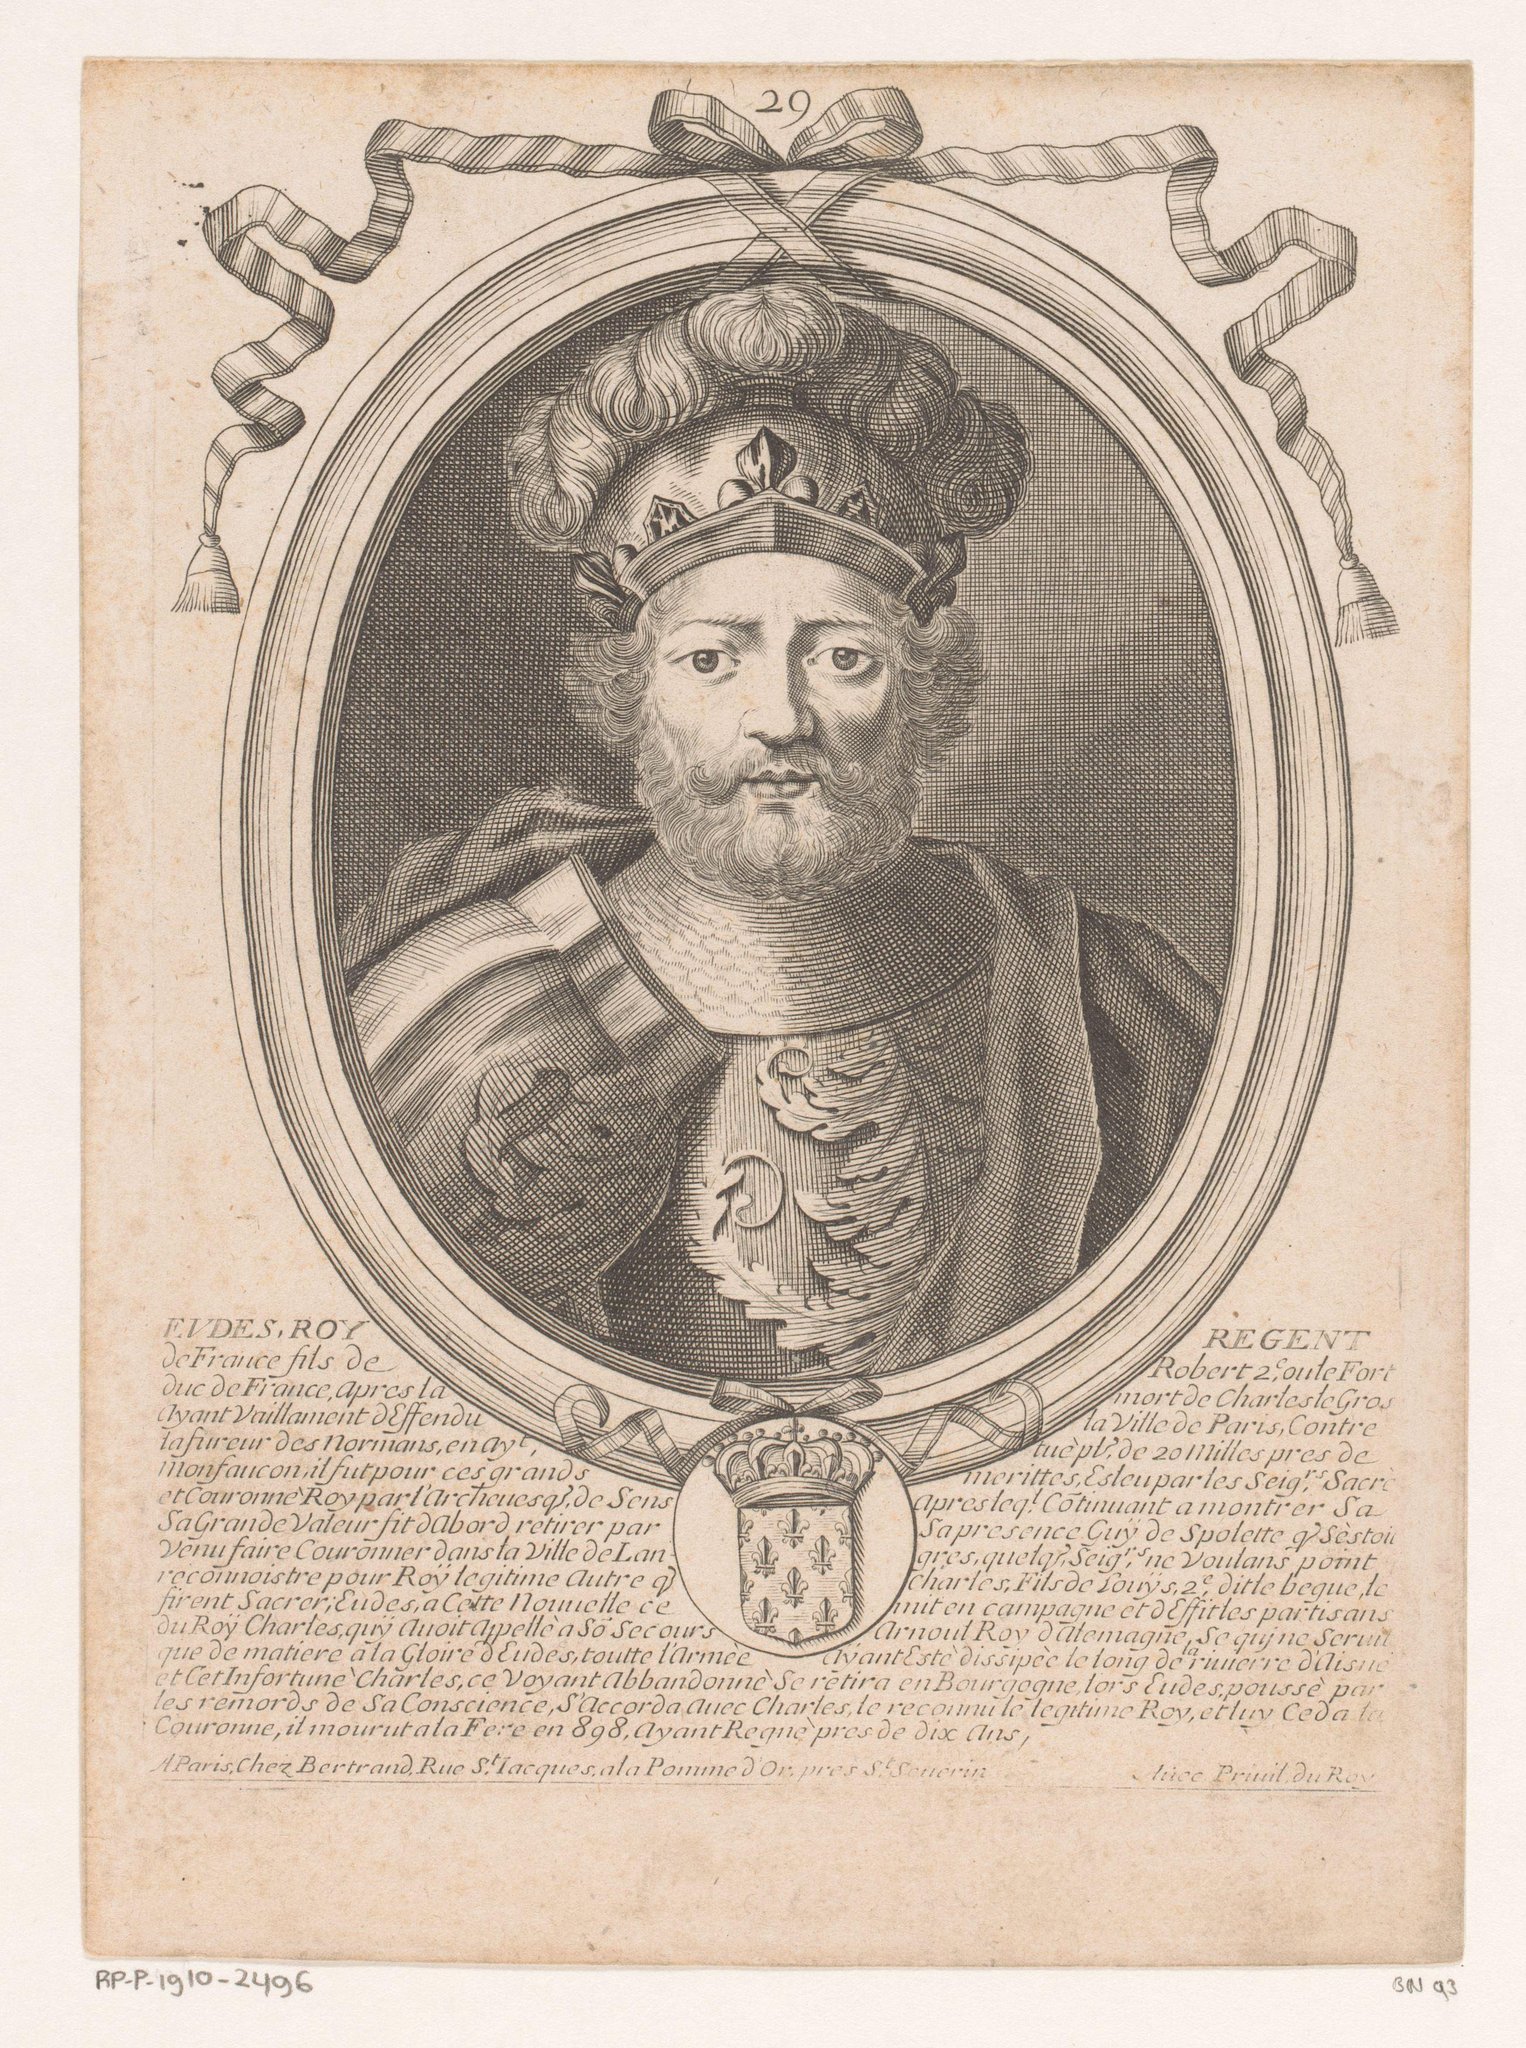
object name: print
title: Portretten van prominente figuren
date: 1647-1678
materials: paper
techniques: engraving, etching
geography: france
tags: historical persons, king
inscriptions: collector's mark: Lugt 2228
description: Maakt deel uit van een grootschalige serie met portretten van prominente figuren. Binnen de serie bevindt zich een sectie getiteld 'Les Augustes Représentations De tous les Roys De France depuis Pharamond Iusqu'à Louys XIIII'. De serie werd respectievelijk uitgegeven door Pierre Bertrand, door zijn weduwe en door De Larmessin zelf.